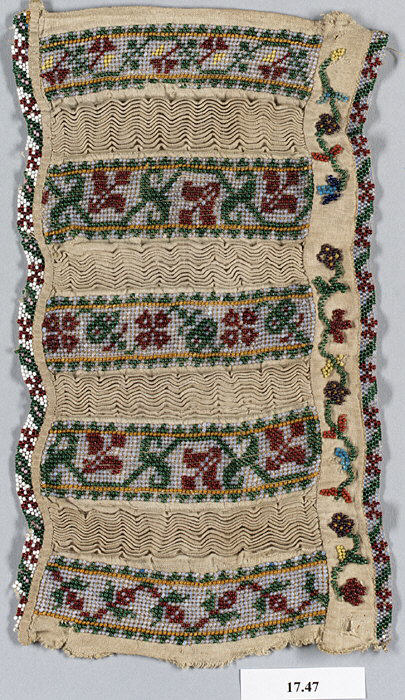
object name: sampler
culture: mexican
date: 1801-1900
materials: linen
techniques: embroidery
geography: mexico